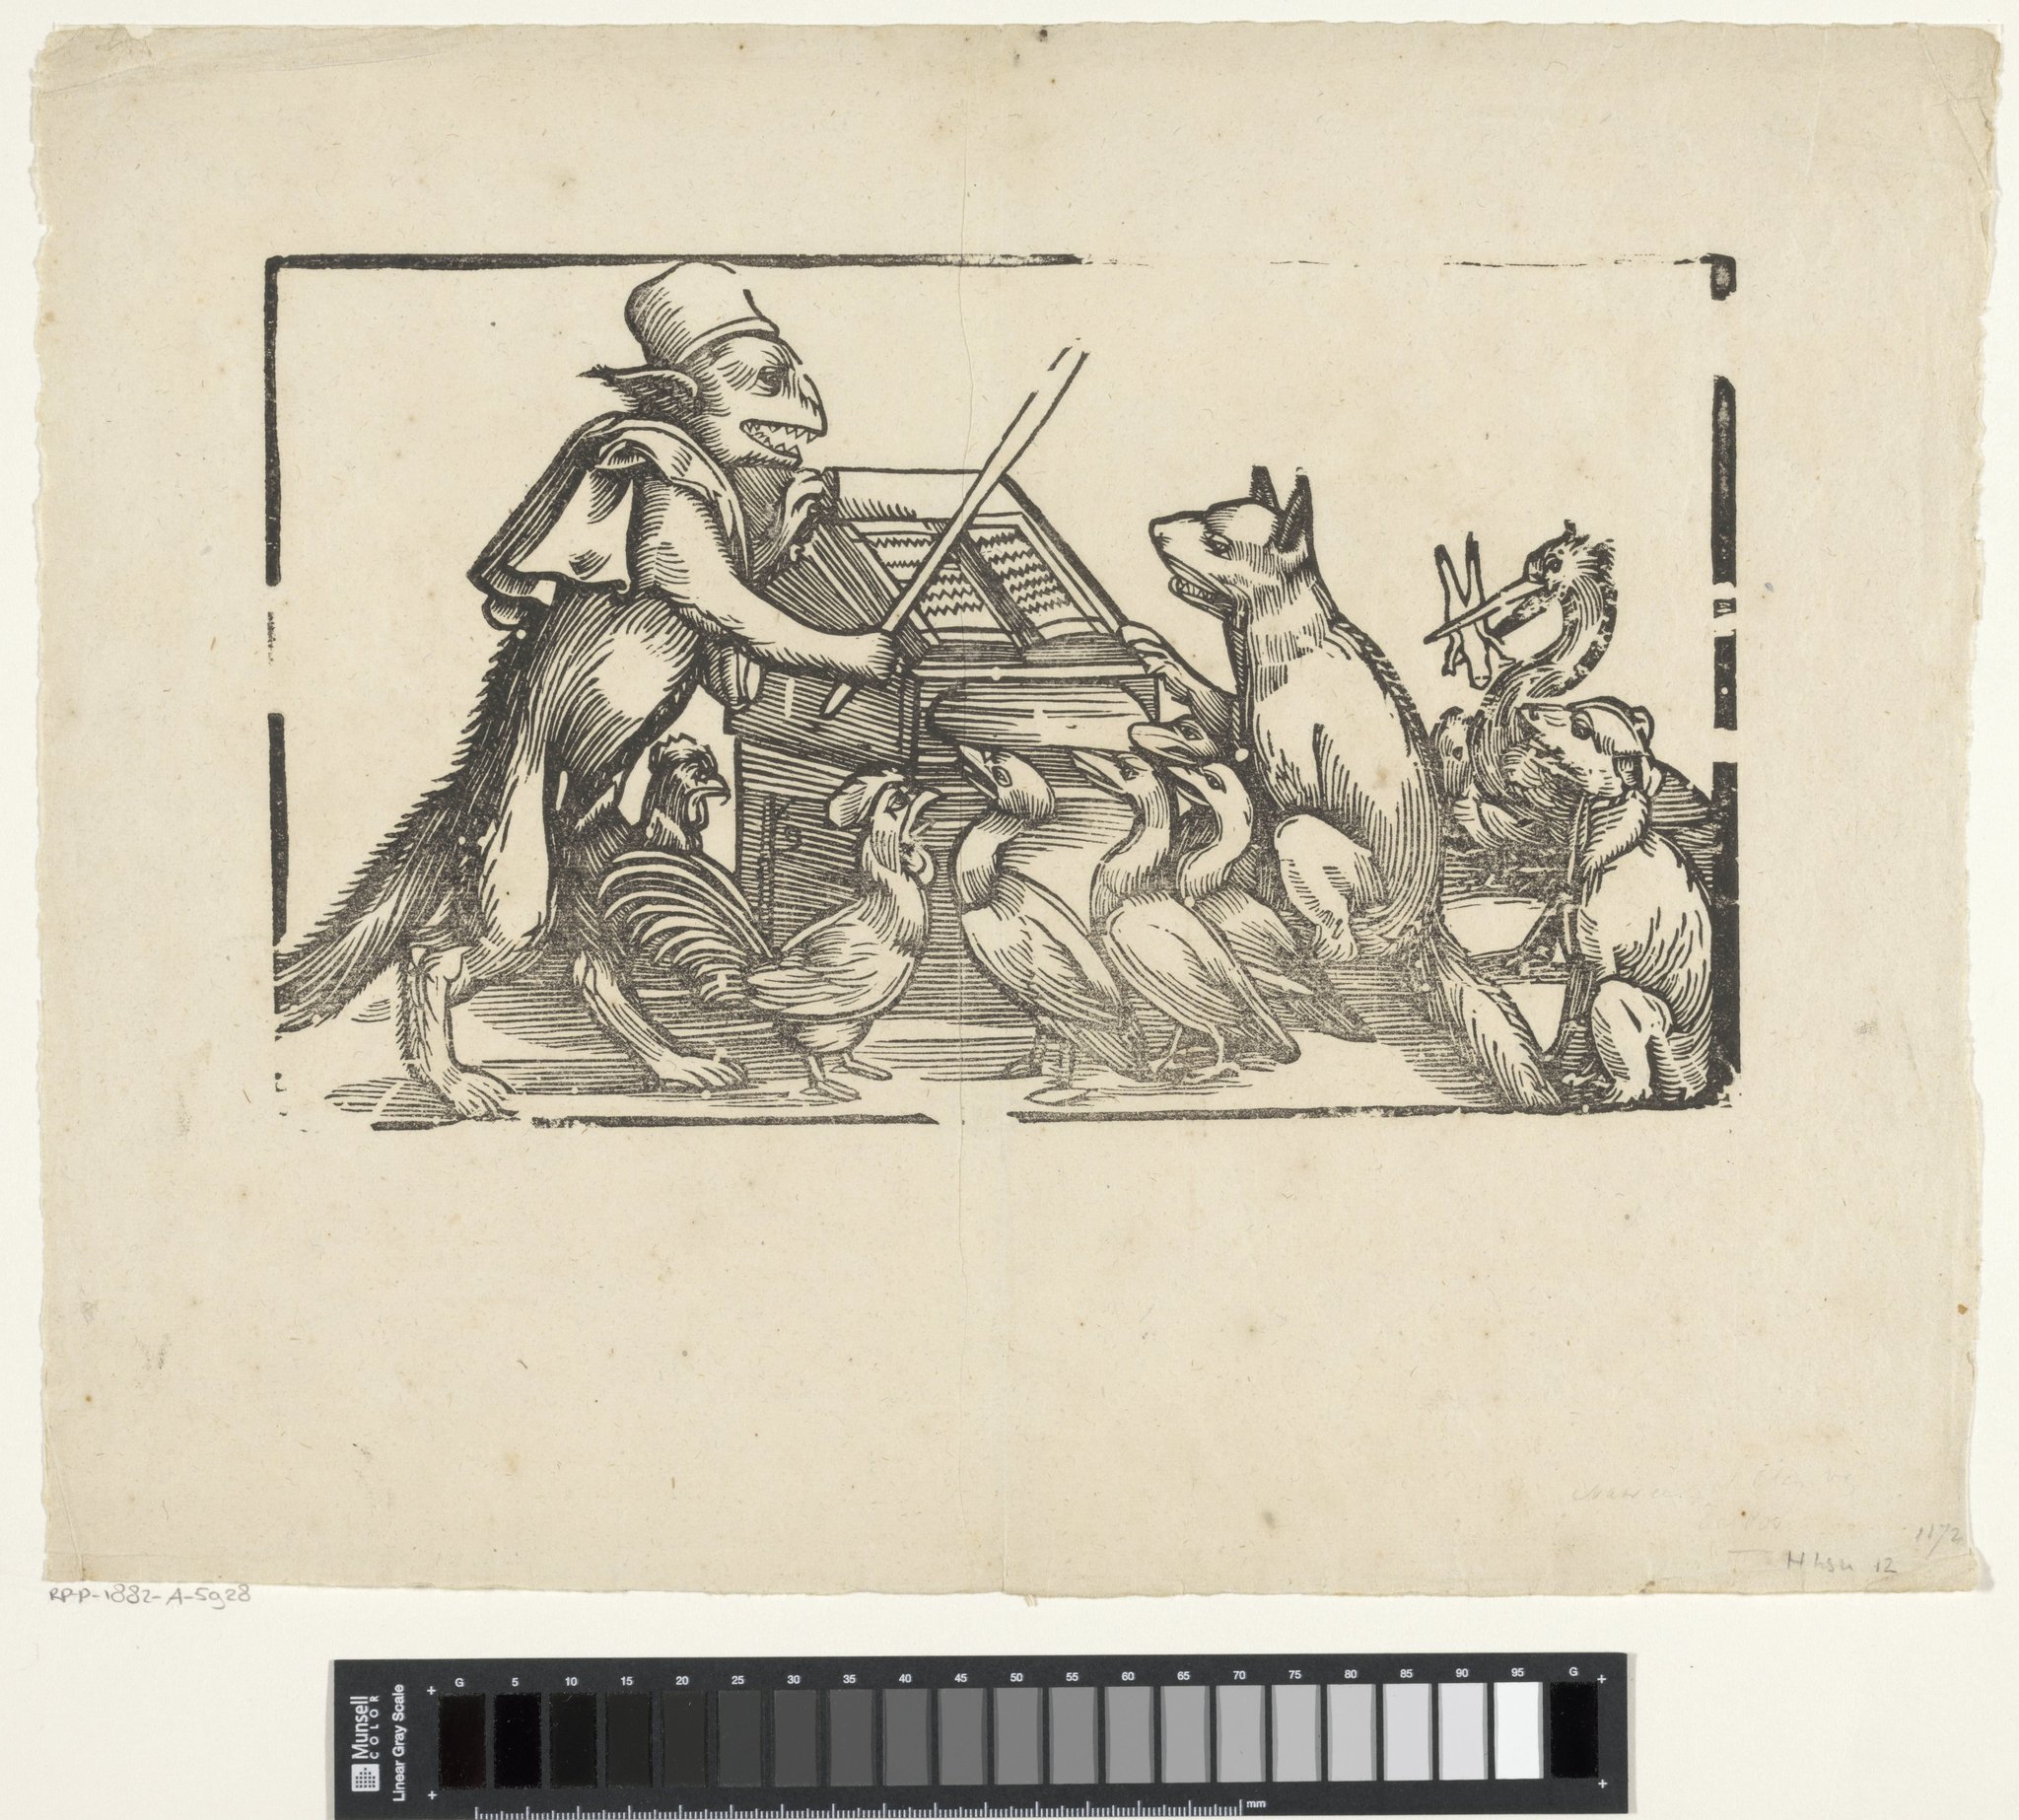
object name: print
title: Vos de passie prekend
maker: Anonymous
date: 1600-1699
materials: paper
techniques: woodcut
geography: netherlands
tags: shore-birds and wading-birds: stork, fowl (cock, hen, chicken, etc.), water-birds: duck, dog, beasts of prey, predatory animals: fox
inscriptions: collector's mark: Lugt 2228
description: Een vos staat met een stok in de hand naast een katheder. Een aantal eenden, hanen, een ooievaar en een hond horen toe.